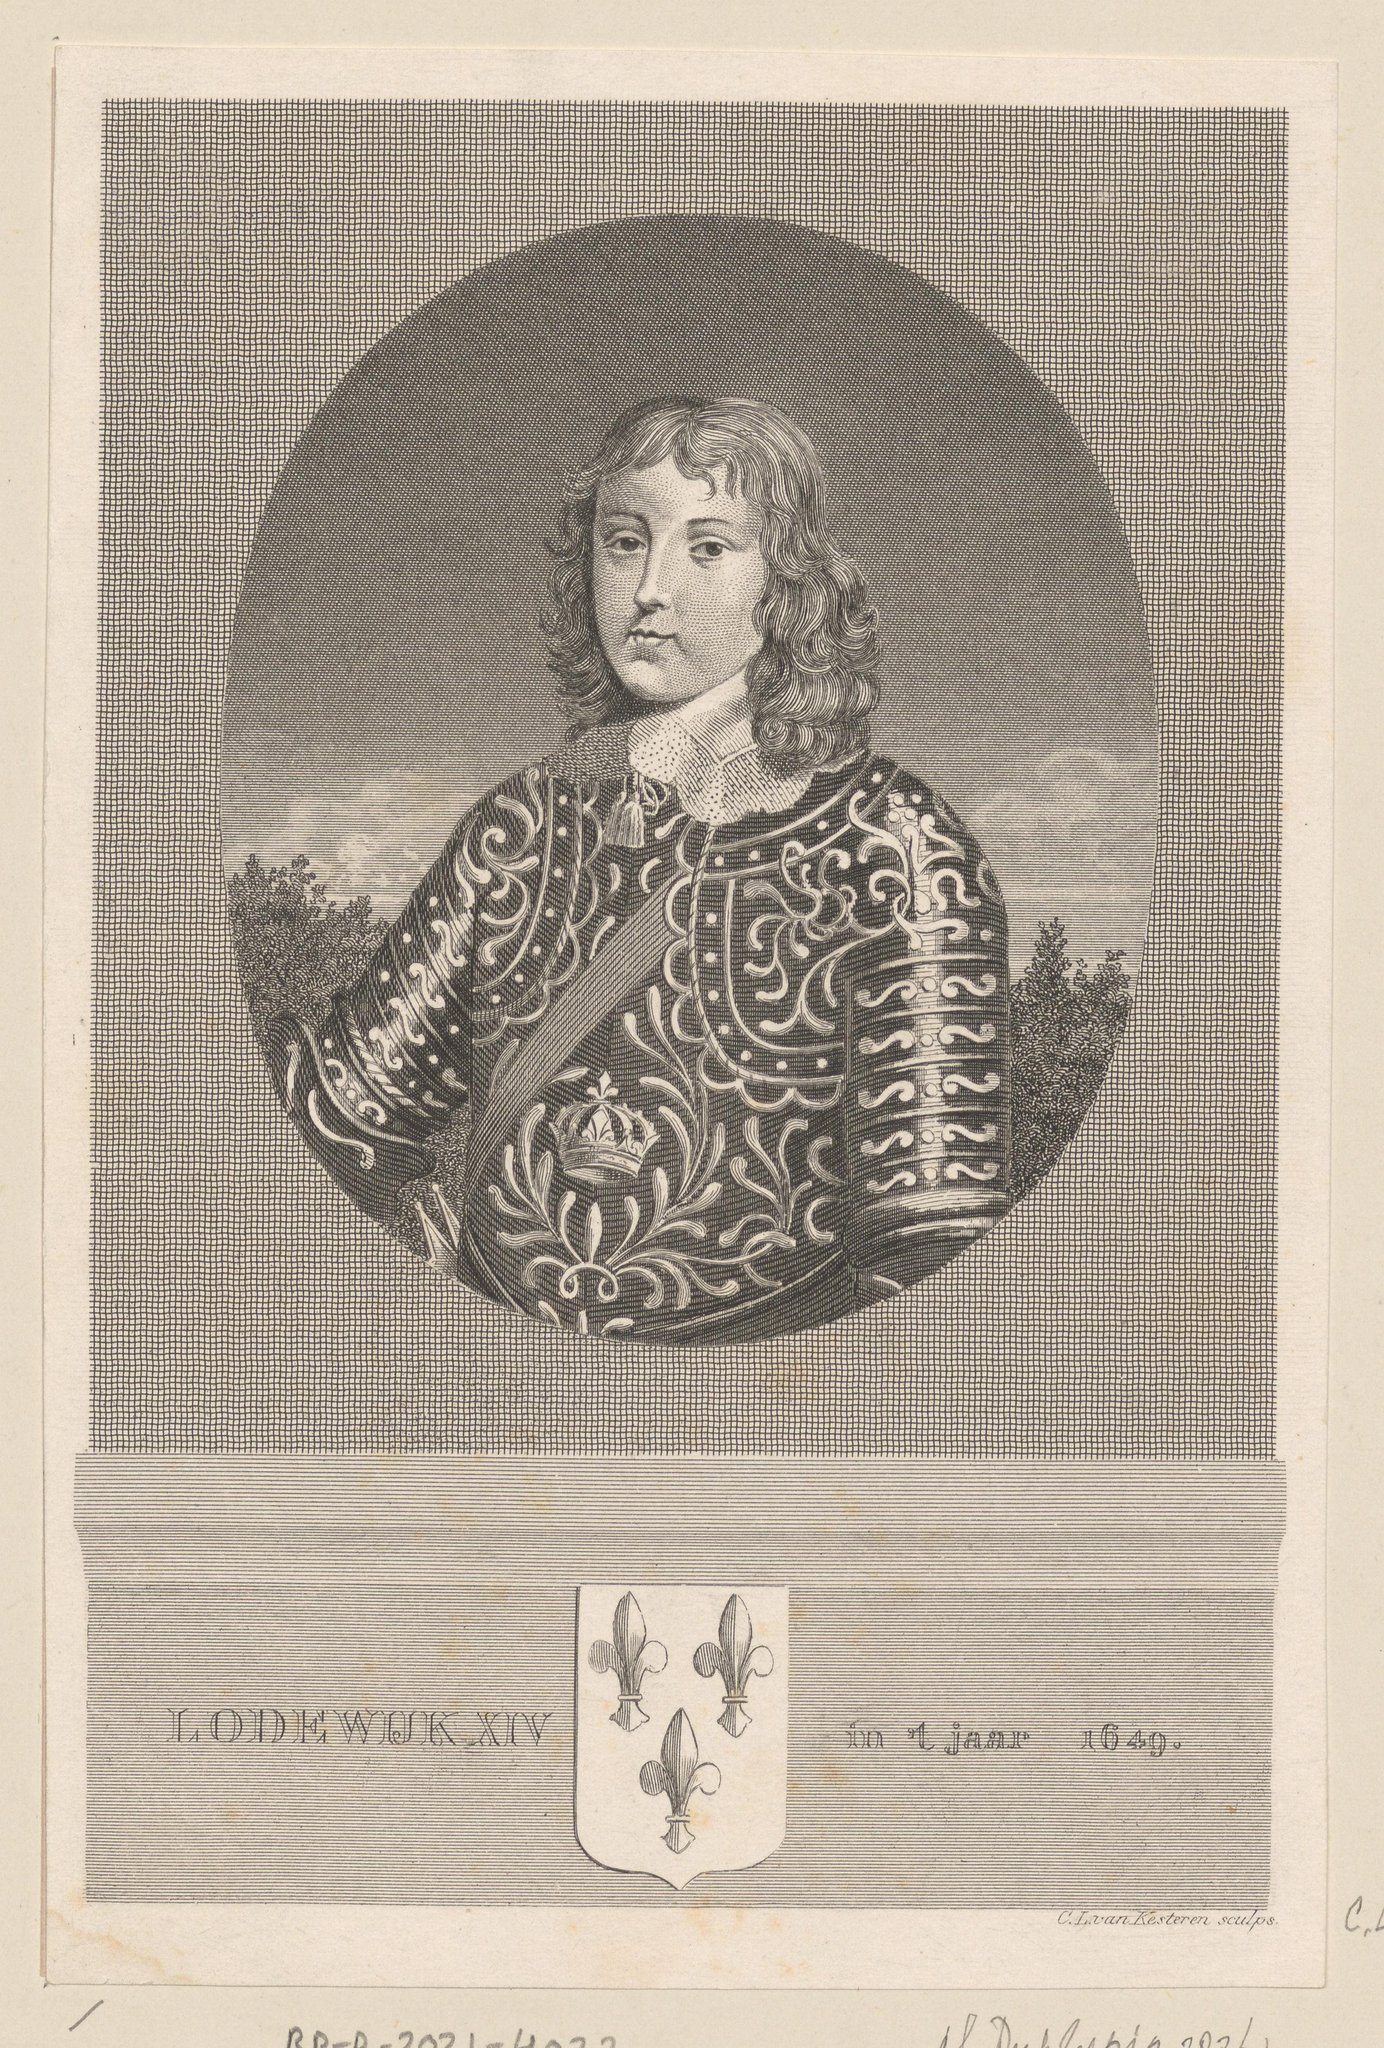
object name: print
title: Portret van Lodewijk XIV van Frankrijk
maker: christiaan lodewijk van kesteren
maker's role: print maker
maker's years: 1832-1897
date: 1879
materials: paper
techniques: engraving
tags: lodewijk xiv (koning van frankrijk), coat of arms (symbol of sovereignty), armour, historical persons, king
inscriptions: number: ‘No. 520’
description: Prent waarschijnlijk uit: Arend, Johannes Pieter en J. van Vloten. Algemeene Geschiedenis des Vaderlands (...). Haarlem: I. de Haan, 1879, dl. 4-1.